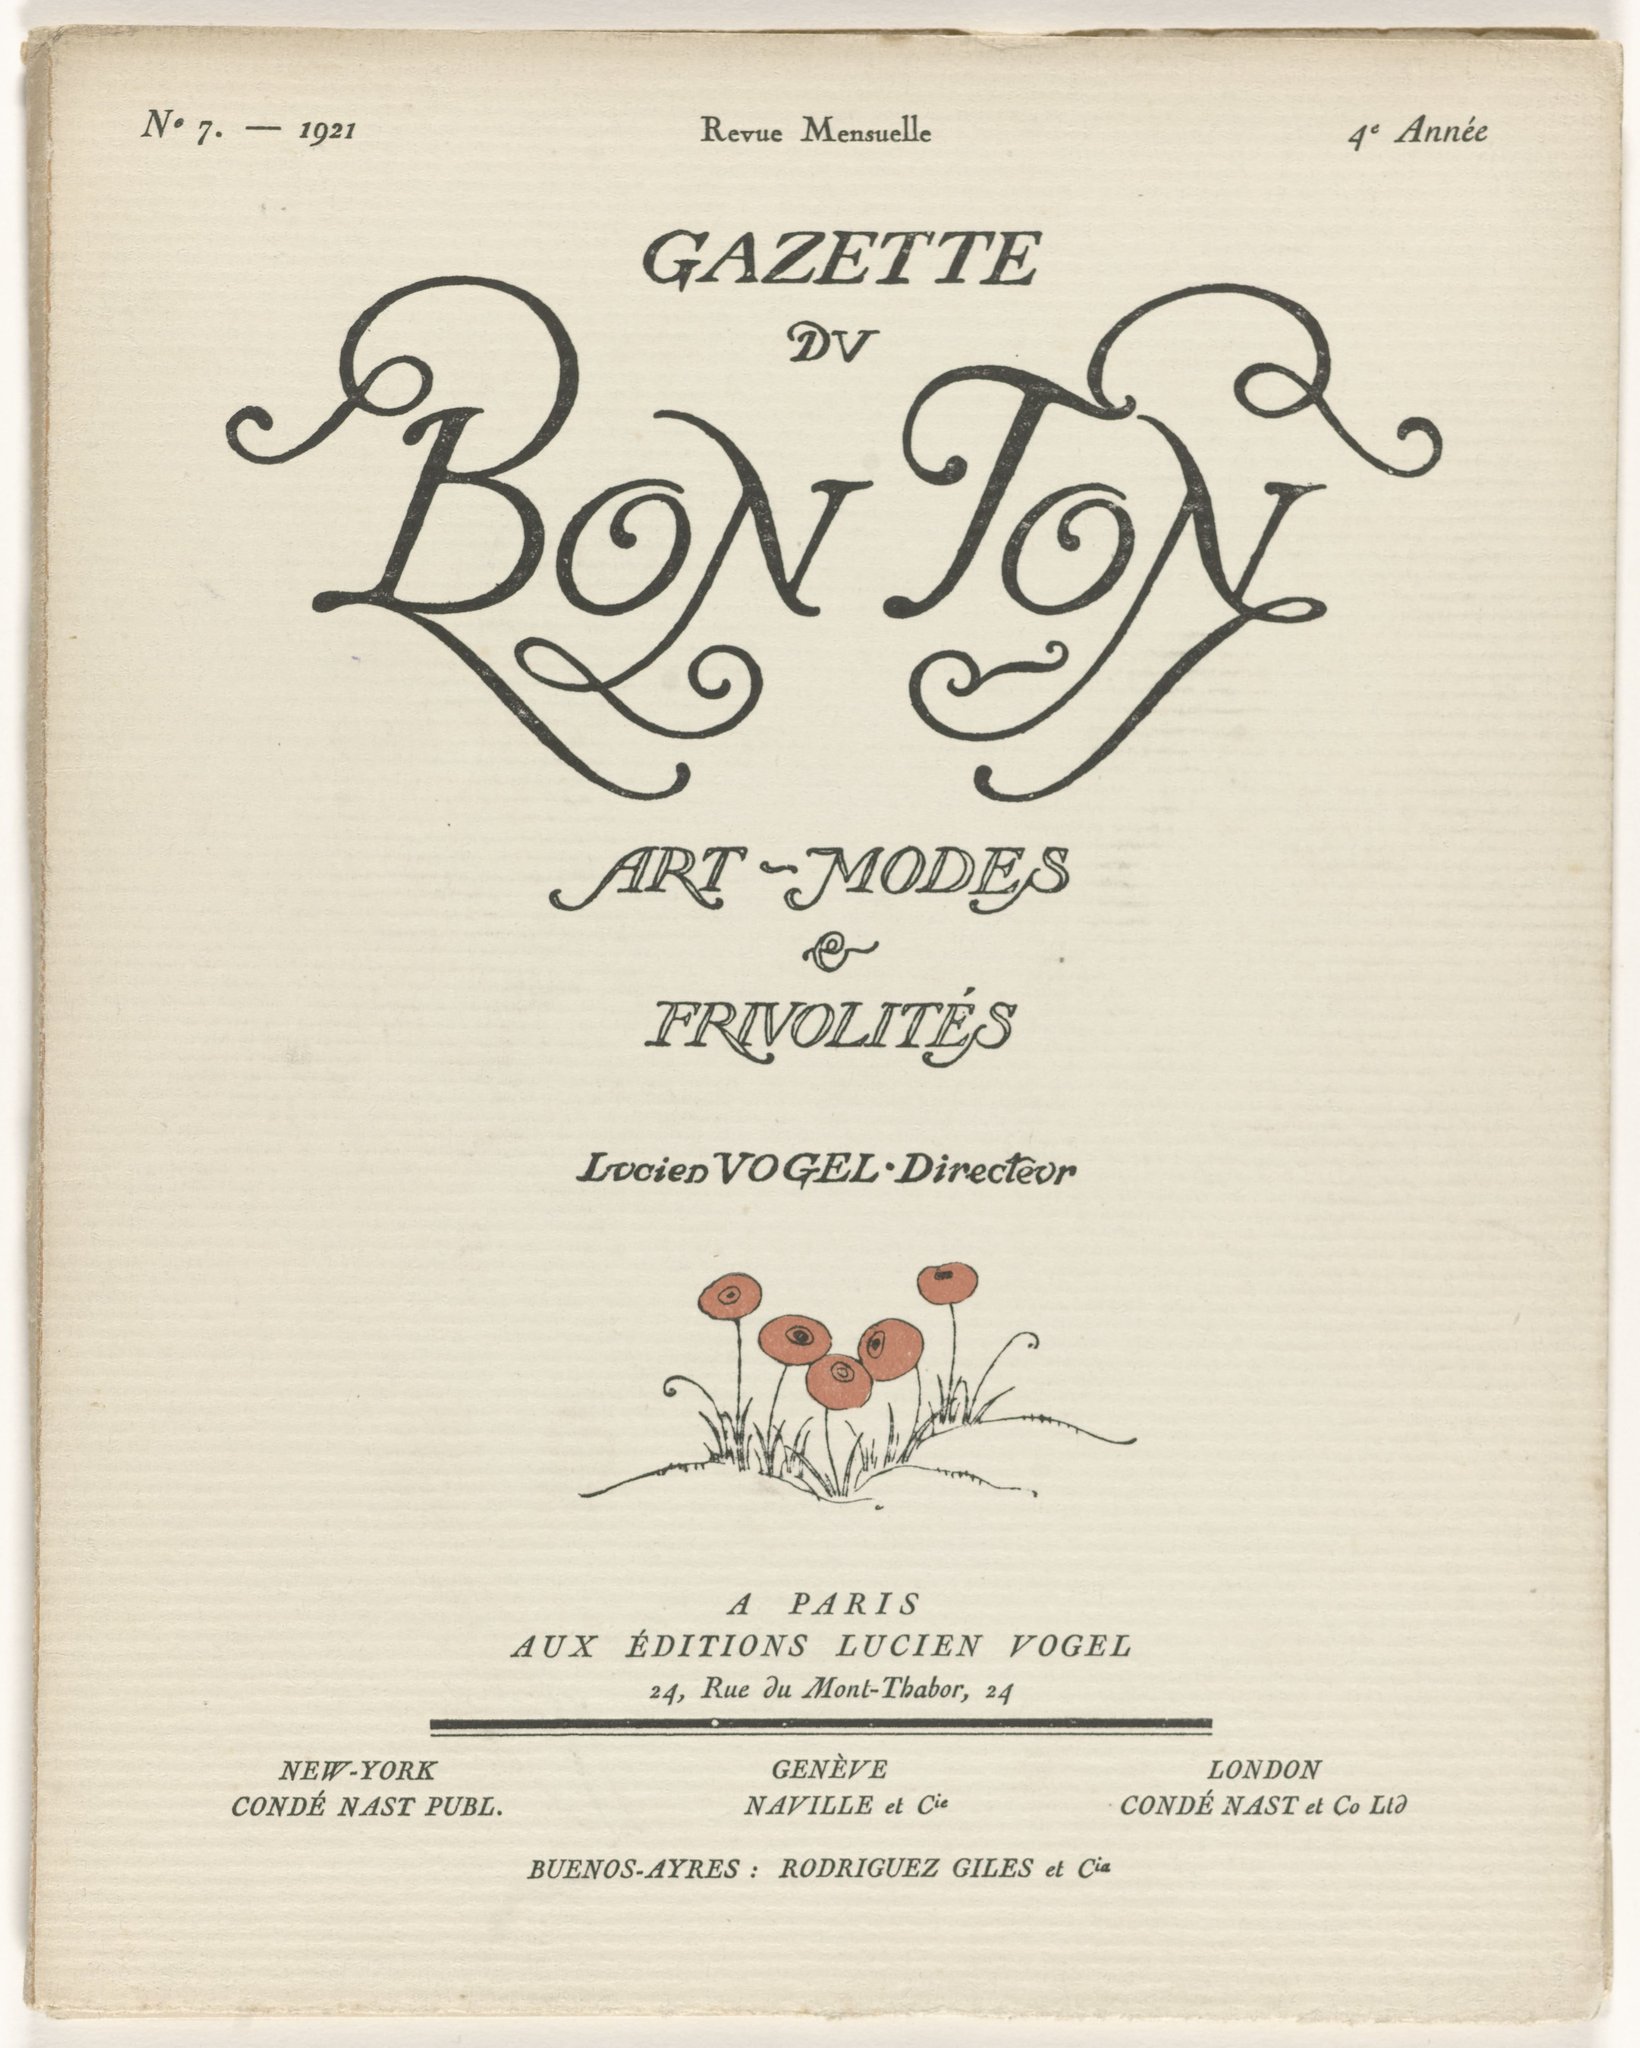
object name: magazine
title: Gazette du Bon Ton. Art - Modes & Frivolités, No. 7 - 1921, 4e Année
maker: lucien vogel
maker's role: publisher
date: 1921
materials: paper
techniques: letterpress printing, pochoir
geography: london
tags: fashion plates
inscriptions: date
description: Aflevering no. 7, september 1921, van Gazette du Bon Ton, bestaand uit een omslag, tien katernen met tekst en illustraties en acht losse prenten. Aan dit deel werkten de volgende modeontwerpers mee: Beer, Doeuillet, Lanvin, Paul Poiret, Camille Roger en Worth.